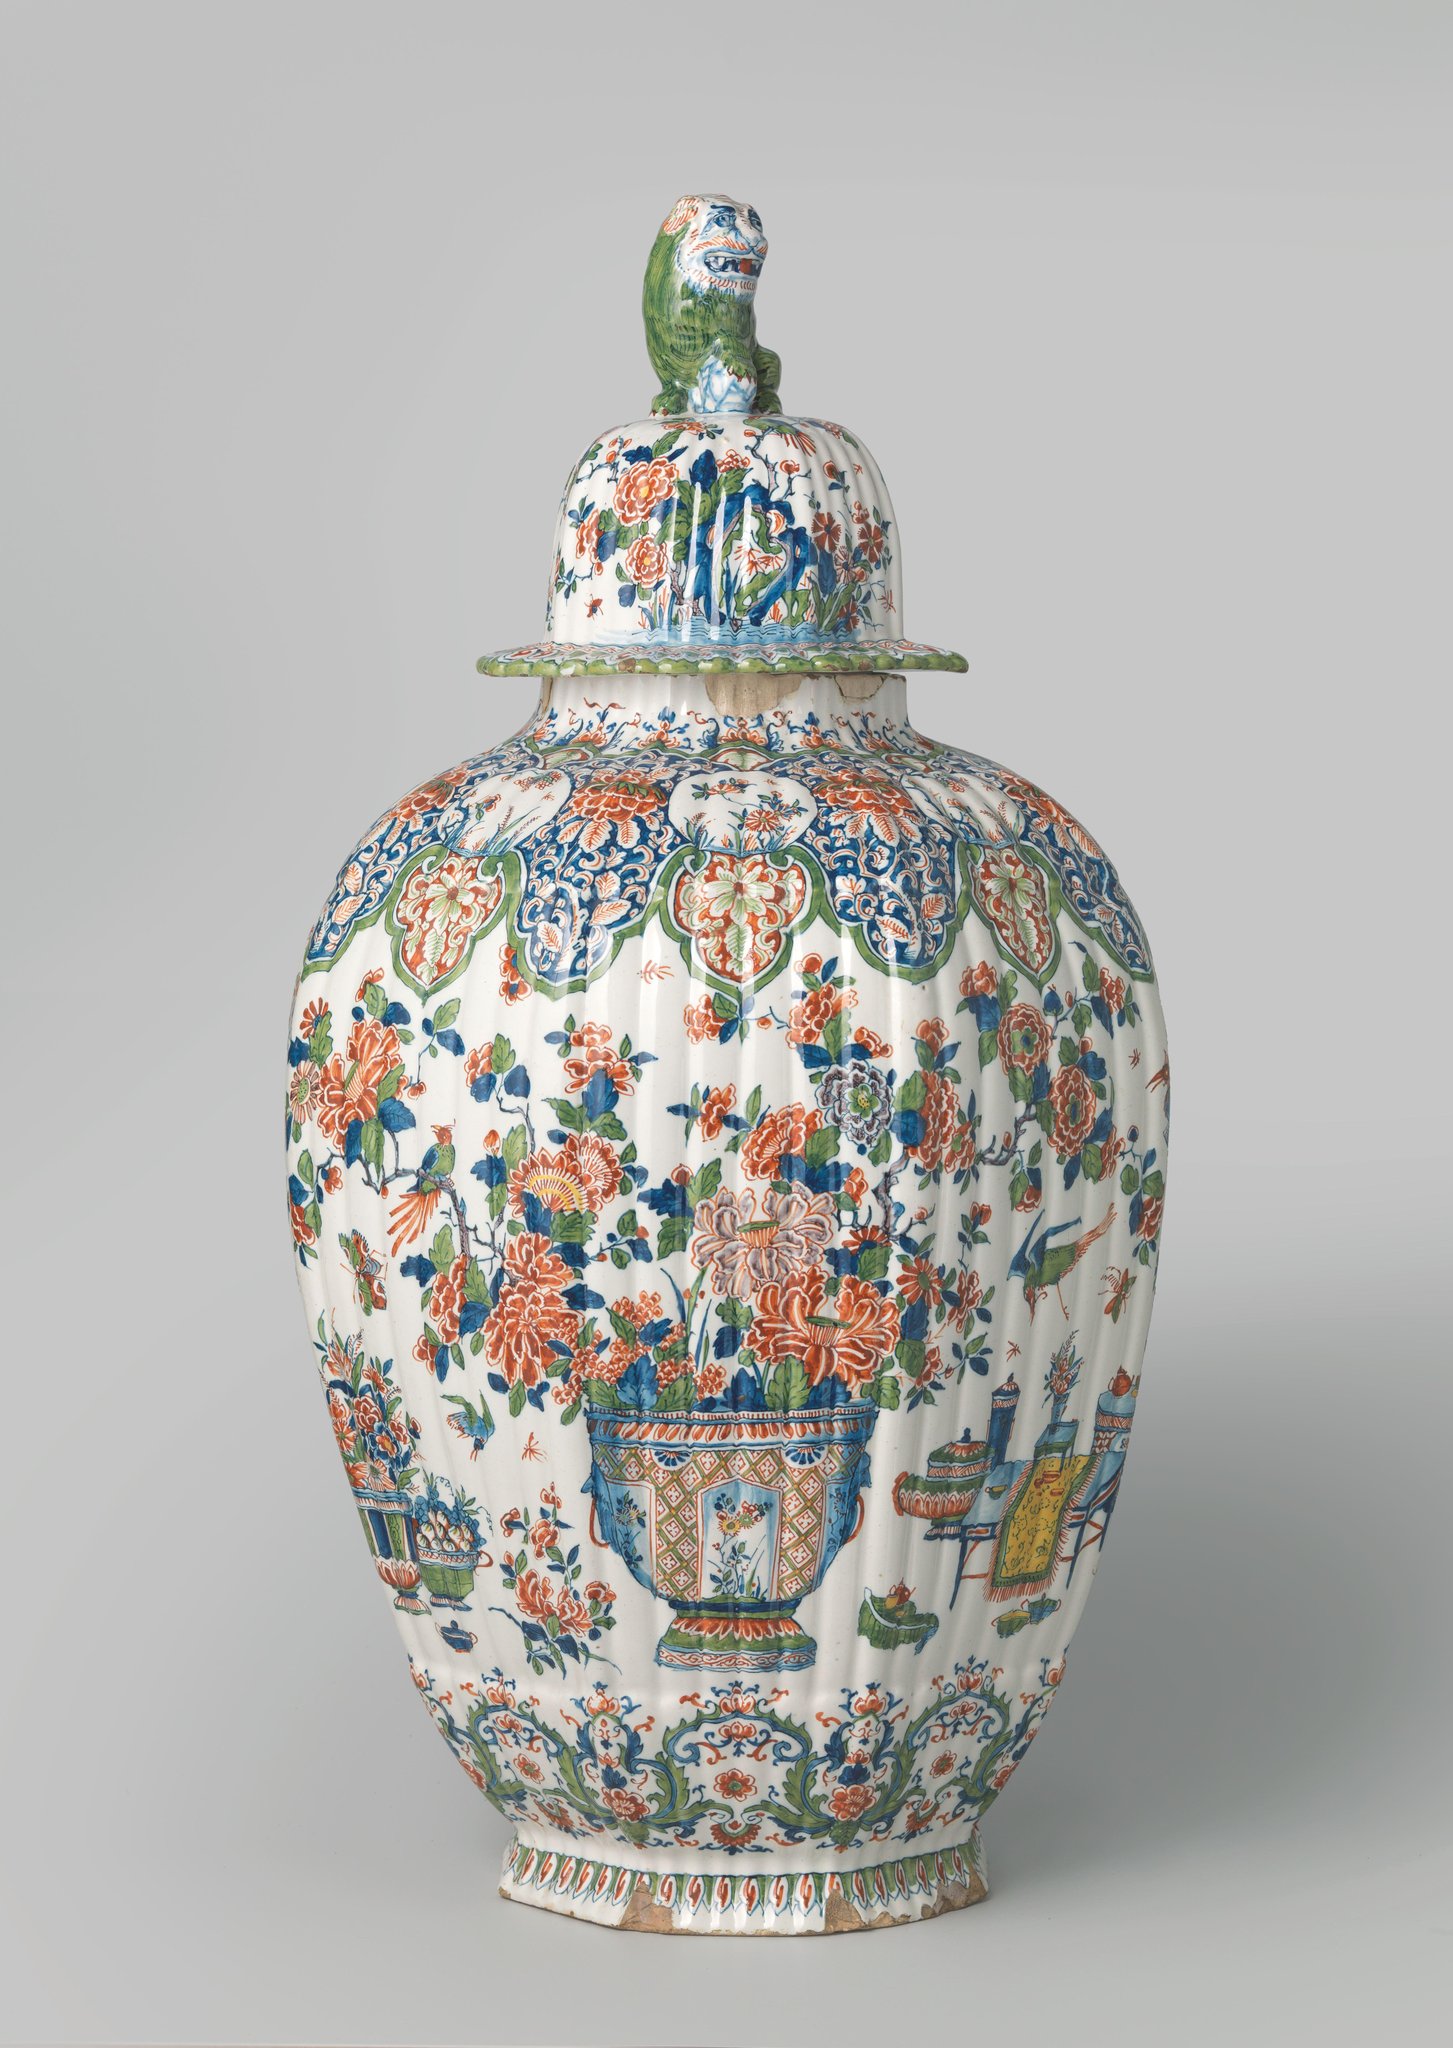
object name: lid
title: Deksel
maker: lambertus van eenhoorn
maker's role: plateelbakker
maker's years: 1651-1721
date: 1691-1725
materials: faience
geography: delft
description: Deksel behorend tot een achthoekige geribde dekselvaas met polychroom decor. Op het deksel vergelijkbare bloemschilderingen als op de vaas. Het deksel wordt bekroond door een groene leeuw, met één poot op een bol.